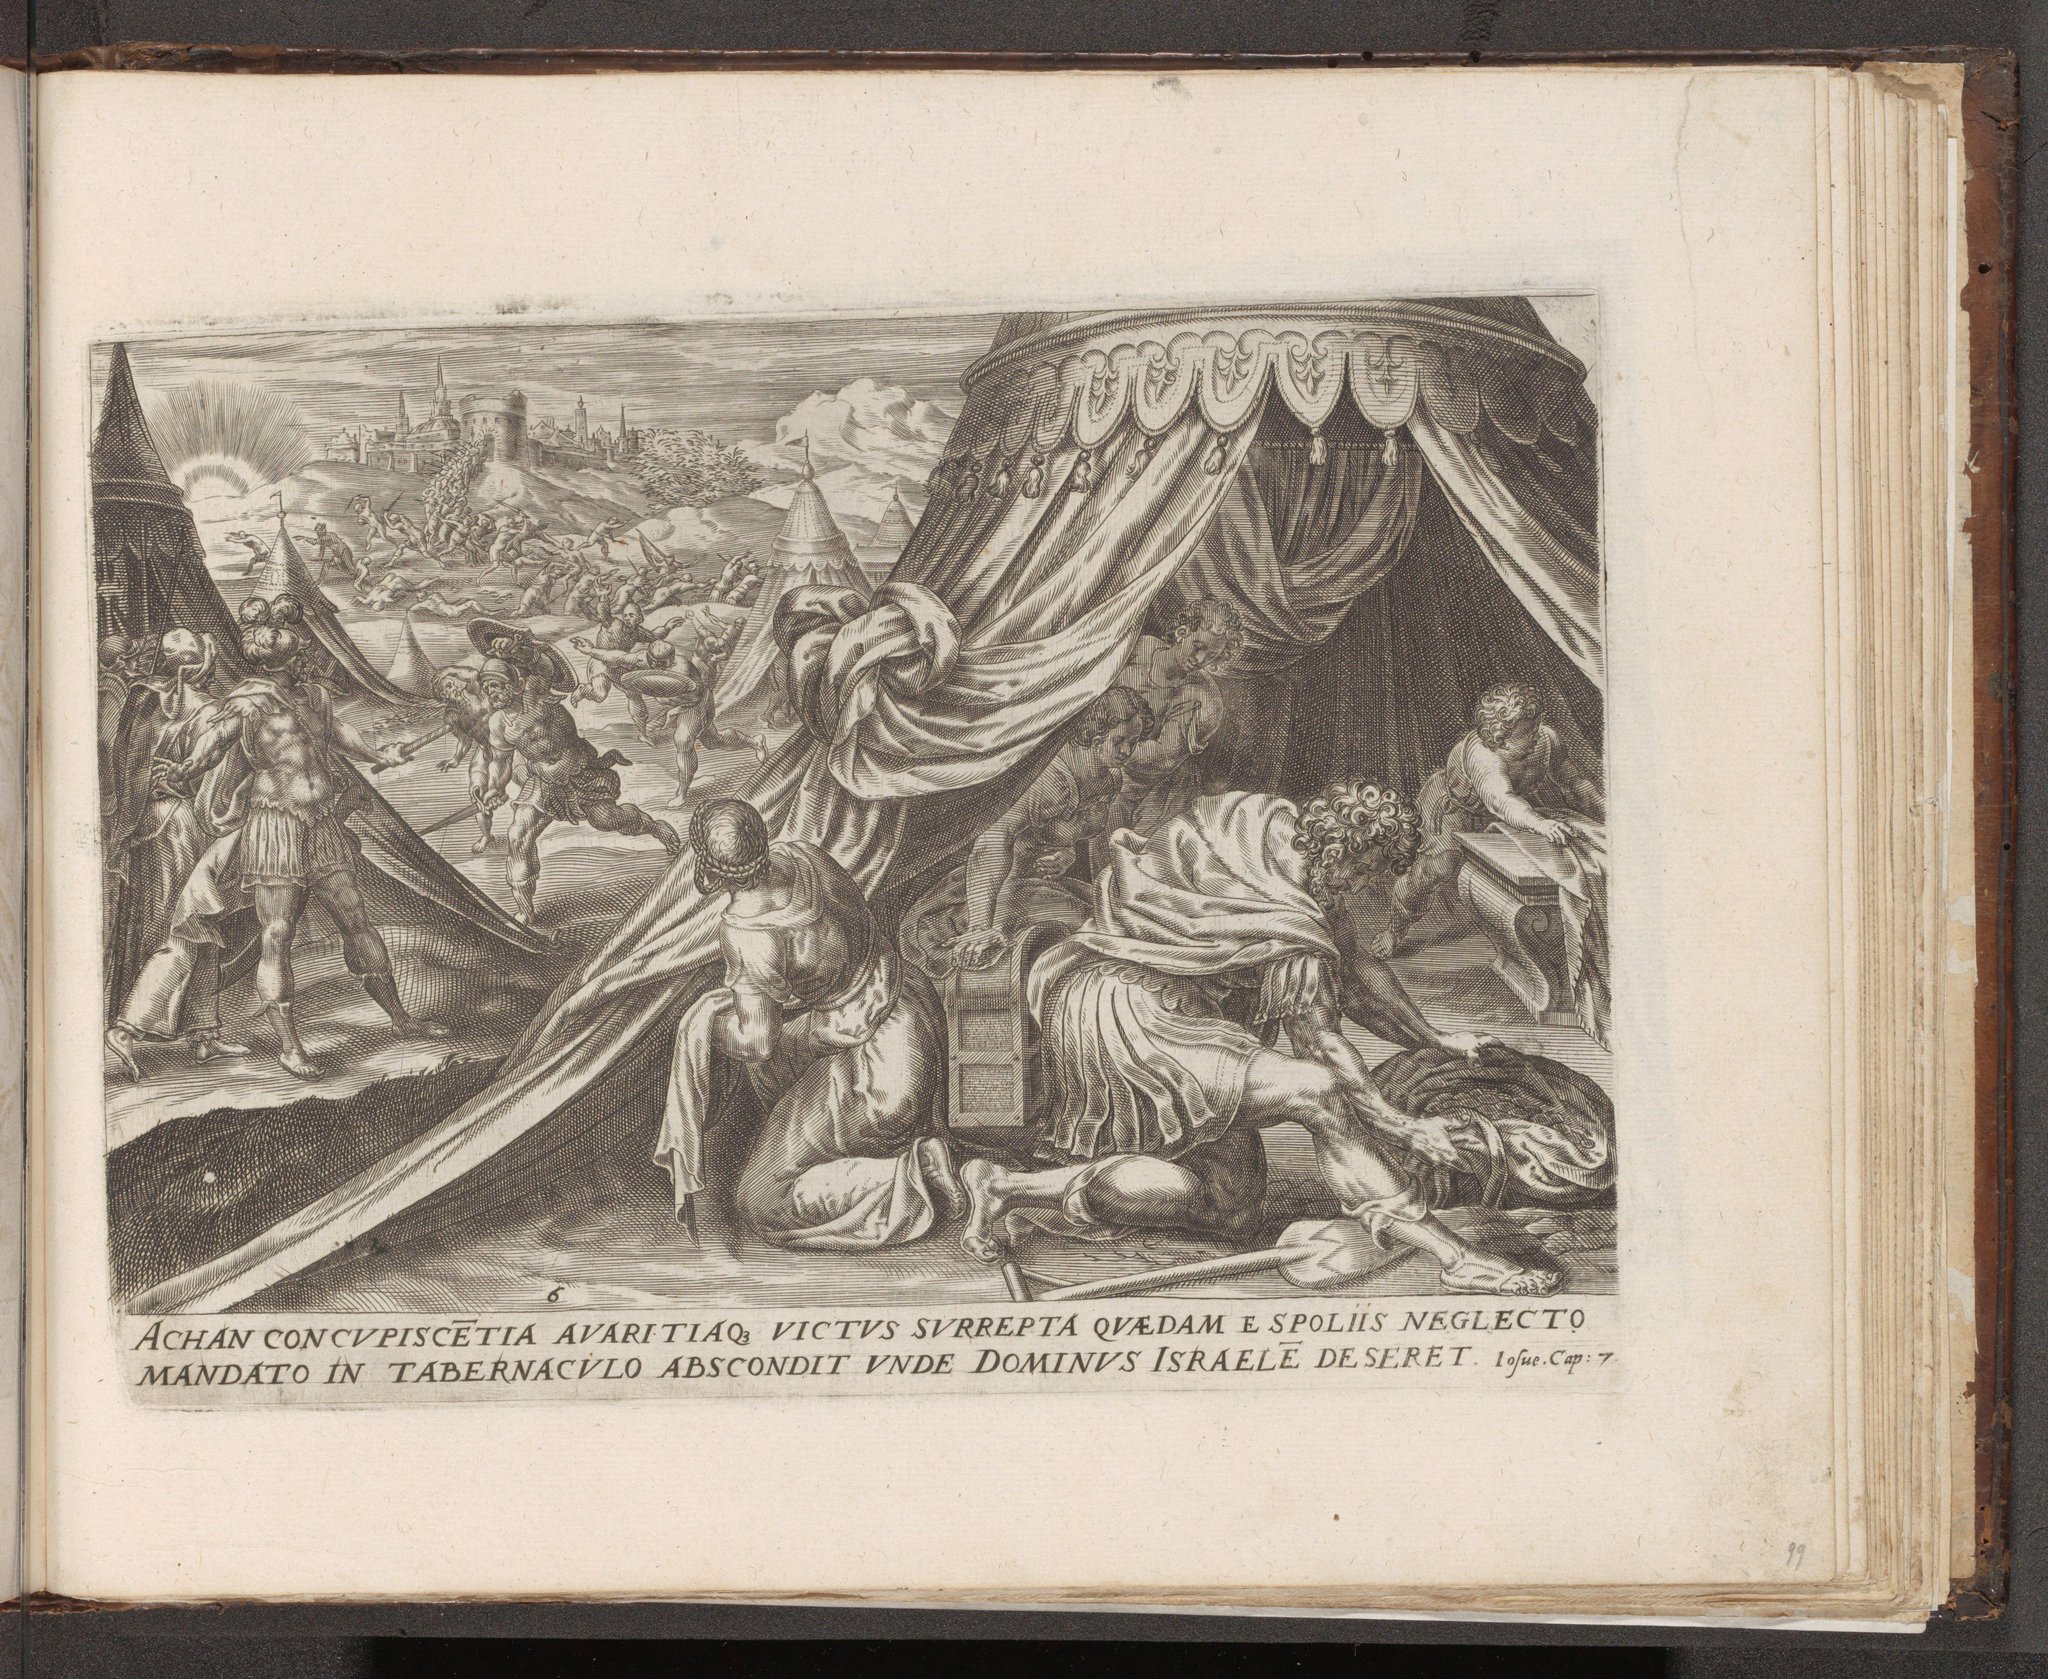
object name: album leaf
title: Achan begraaft de oorlogsbuit in zijn tent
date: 1579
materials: paper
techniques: engraving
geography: antwerp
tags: only three thousand men go up against ai; they are driven back and some of them are slain, achan's sin (aftermath of the fall of jericho) (joshua 7)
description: Achan begraaft de oorlogsbuit, die bestemd was voor God, in zijn tent. Zijn familie helpt hem daarbij. Op de achtergrond slaan de Israëlieten op de vlucht voor het leger van de stad Ai. Links staat Jozua met de bevelhebberstaf in zijn hand. Onder de voorstelling een verwijzing in het Latijn naar de Bijbeltekst in Joz. 7. Prent maakt deel uit van een album.